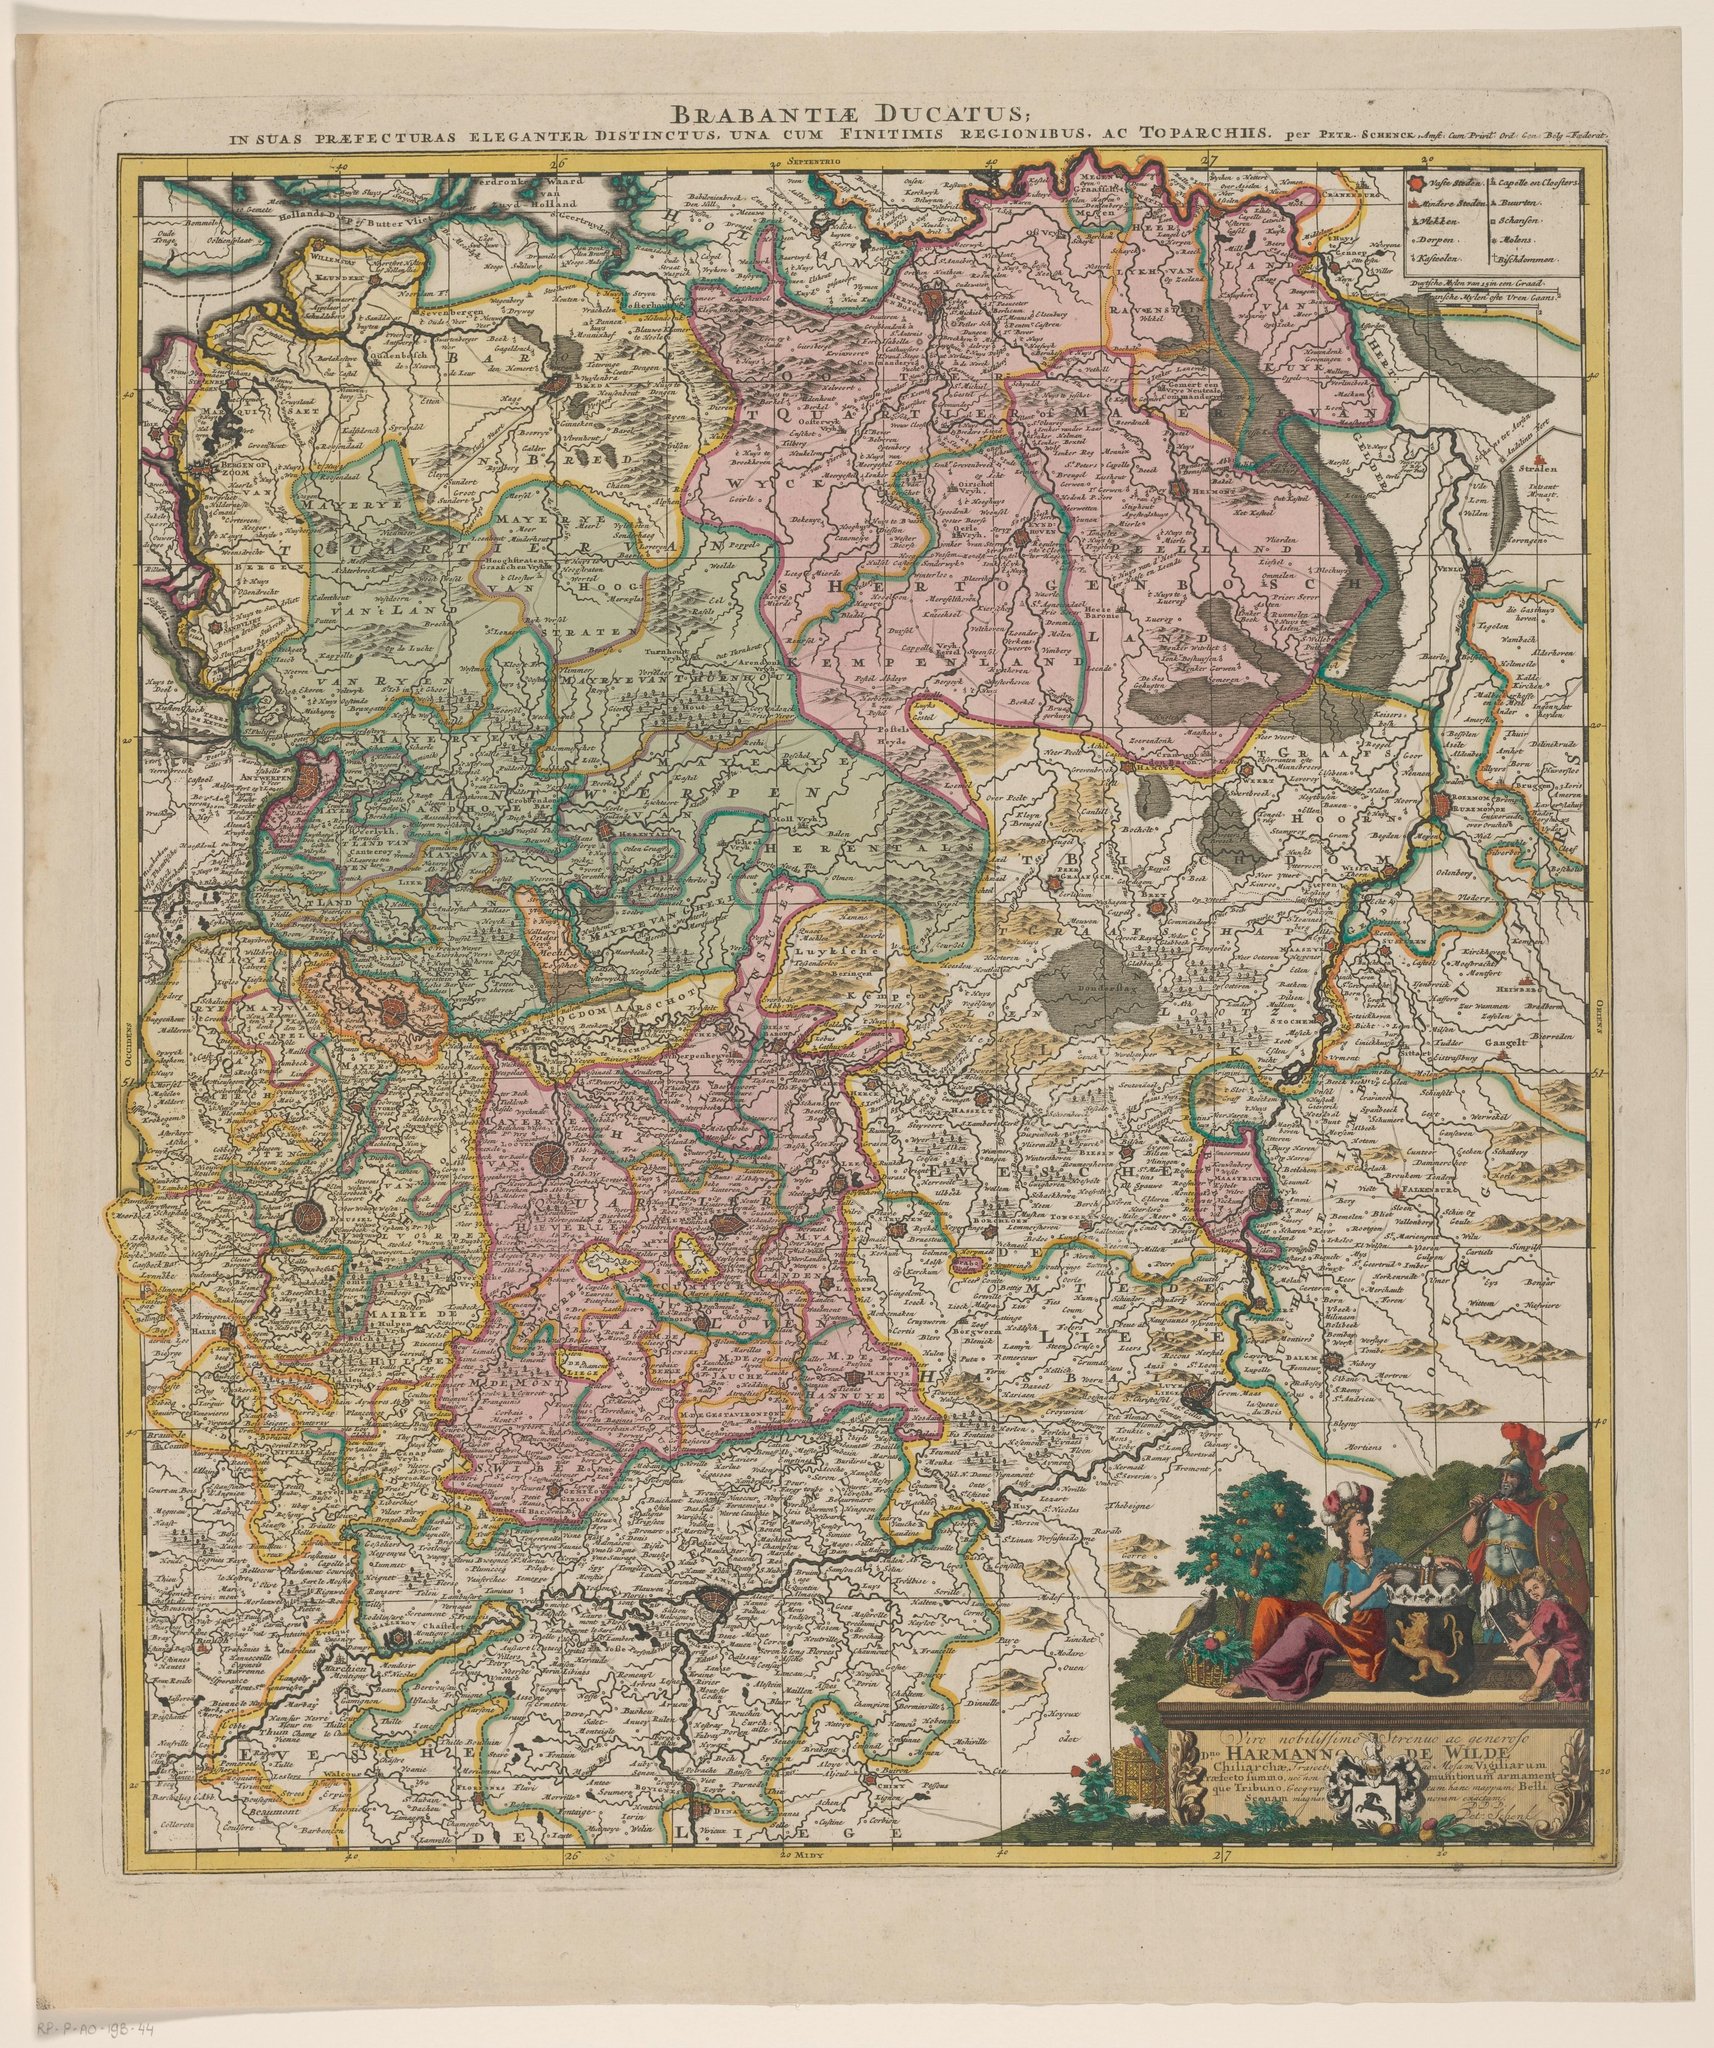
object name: print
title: Brabantiae ducatus; in suas praefecturas eleganter distinctus (...)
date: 1695-1711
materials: paper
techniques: engraving, etching, hand coloring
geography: amsterdam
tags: maps of separate countries or regions, coat of arms (as symbol of the state, etc.) (+ province; provincial), armorial bearing, heraldry, brabant, antwerp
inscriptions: collector's mark: Lugt 2228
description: Kaart van het hertogdom Brabant. Boven de kaart de titel. Rechtsboven een kader met legenda, daaronder twee schaalstokken: 2 Duytsche Mylen van 15 in een Graad / 2 Fransche Mylen ofte Uren Gaans. Rechtsonder een cartouche met opdracht en het wapen van Herman de Wilde. Daarbovenop het wapen van het hertogdom Brabant. De kaart is voorzien van een coördinaten-net en een gradenverdeling langs de randen.